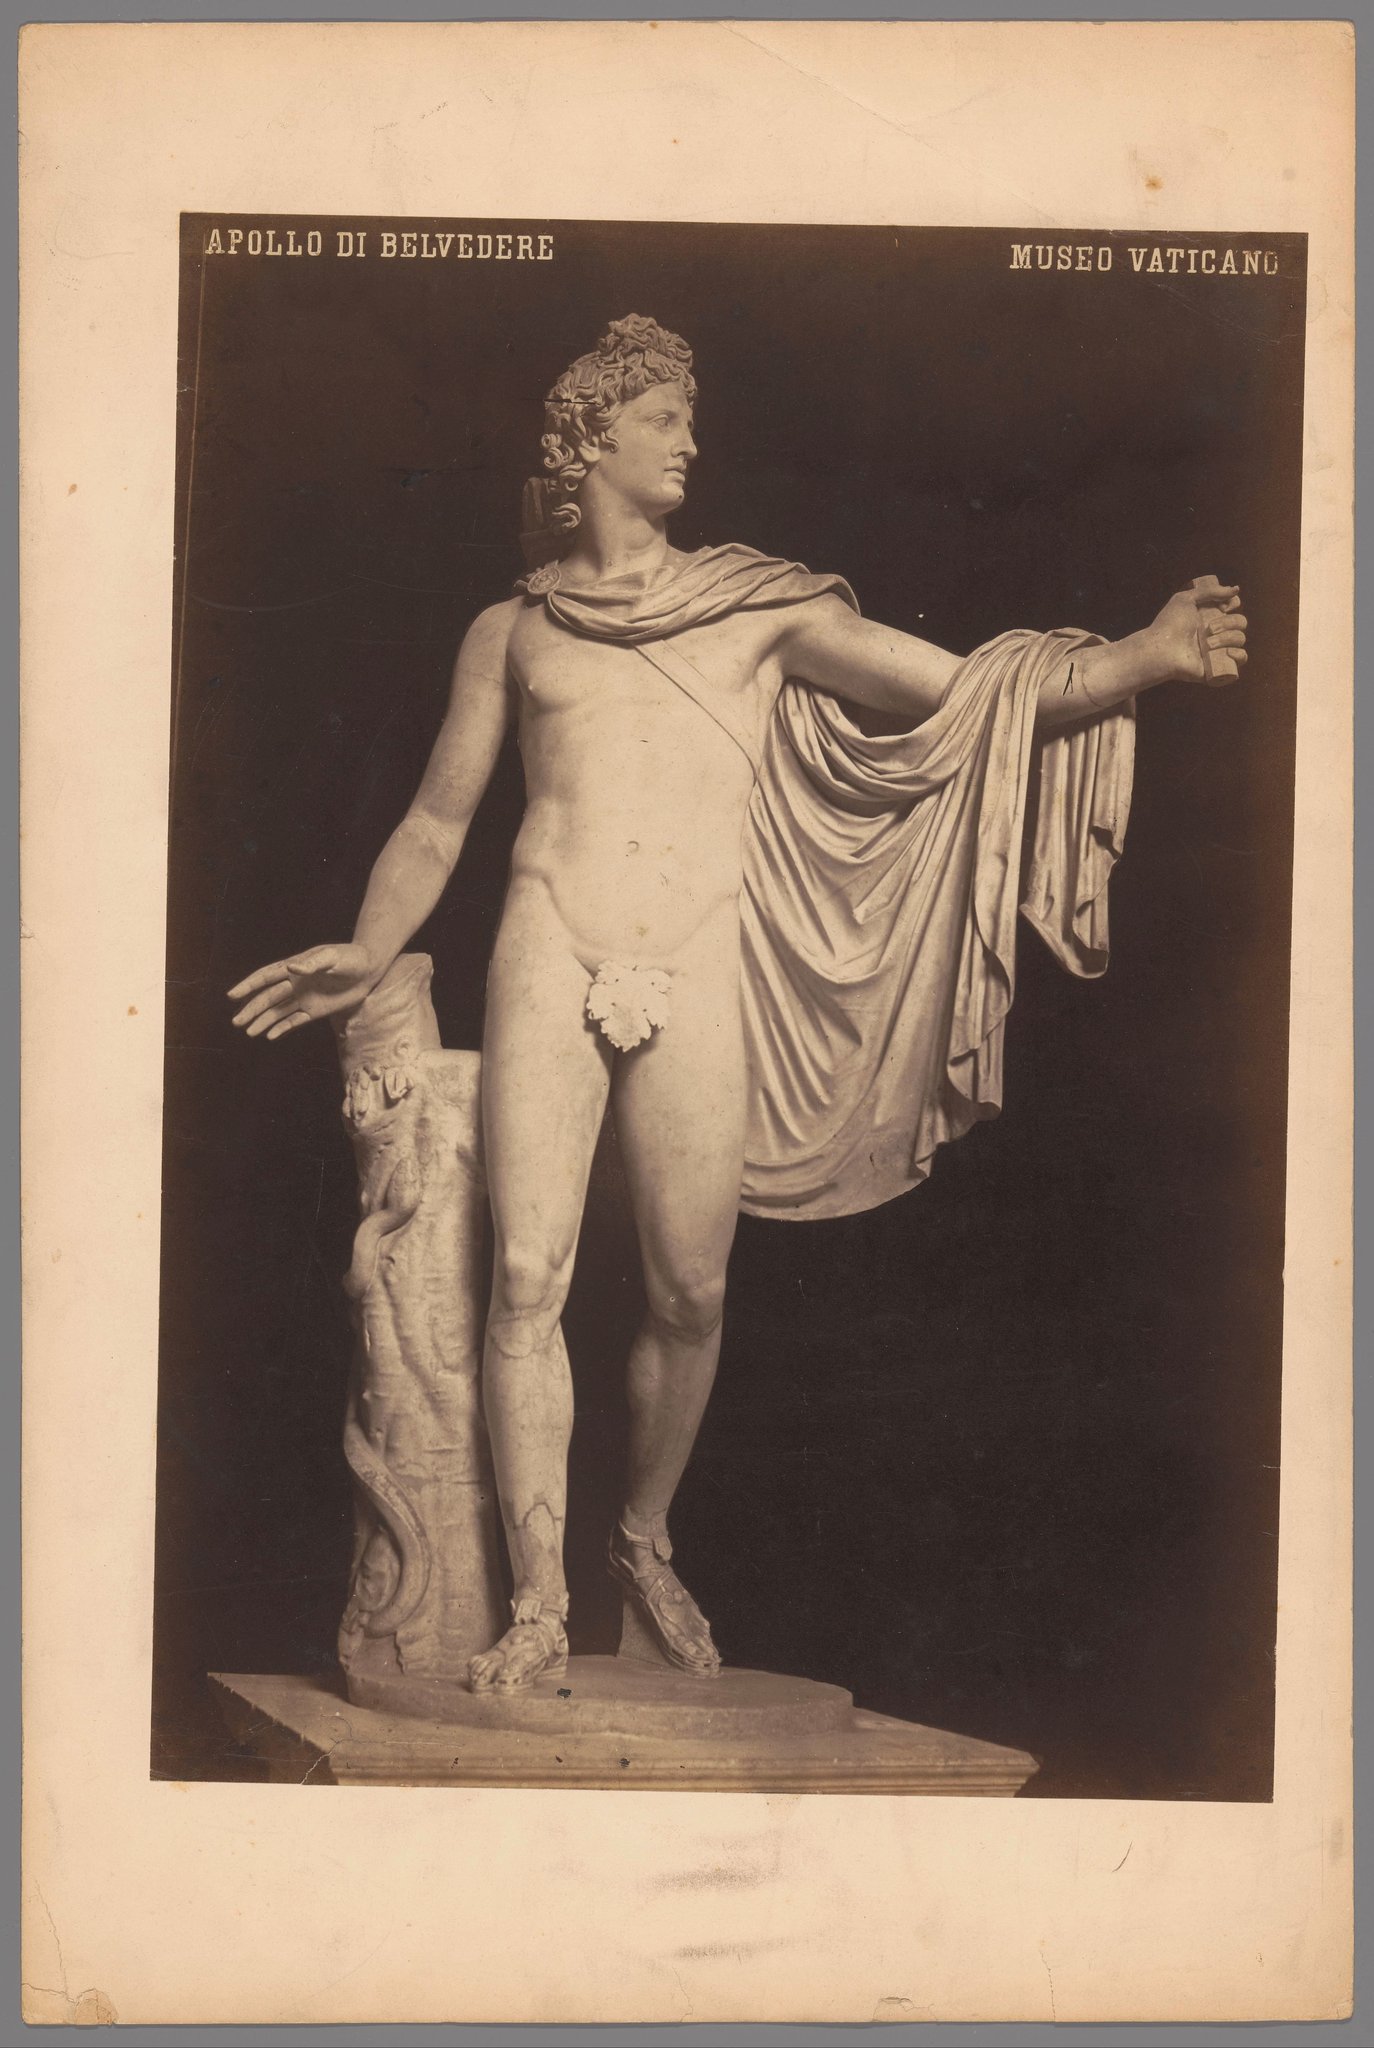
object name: photograph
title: APOLLO DI BELVEDERE MUSEO VATICANO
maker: Anonymous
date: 1875-1900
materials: cardboard, photographic support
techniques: albumen print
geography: vatican museums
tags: (story of) apollo (phoebus), sculpture, man (showing himself) undressed, quasi-nude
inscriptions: collector's mark: Lugt 3937